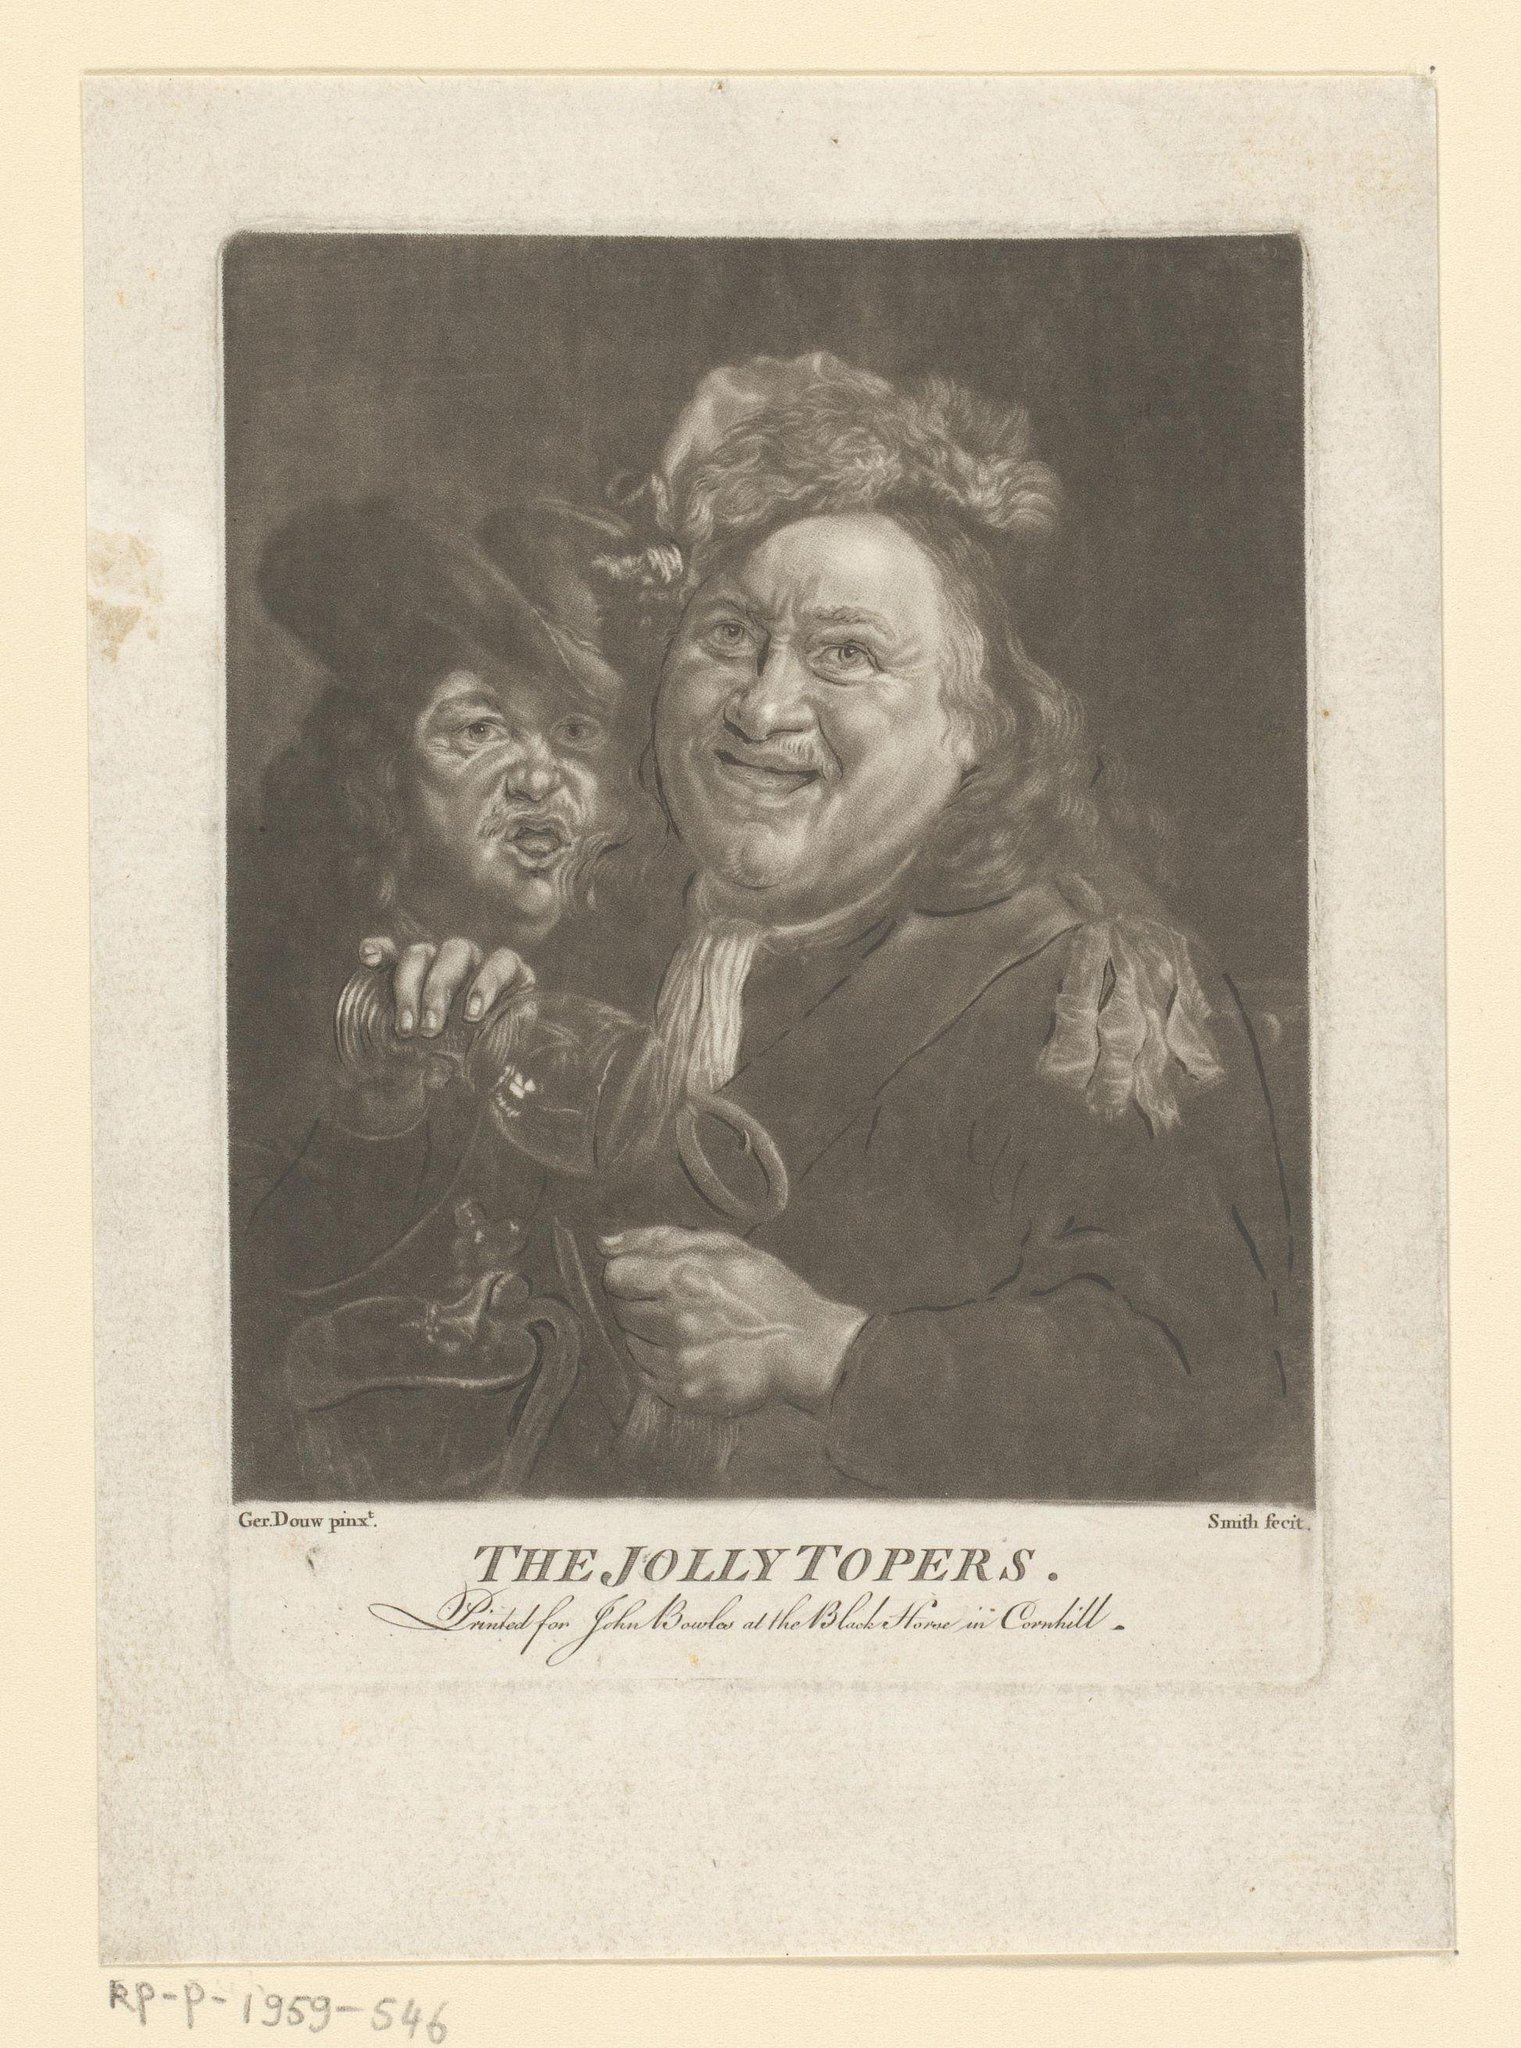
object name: print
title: Twee drinkende mannen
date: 1723-1779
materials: paper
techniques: mezzotint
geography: london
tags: drunkenness, drinking, hotel, hostelry, inn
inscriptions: collector's mark: Lugt 2228